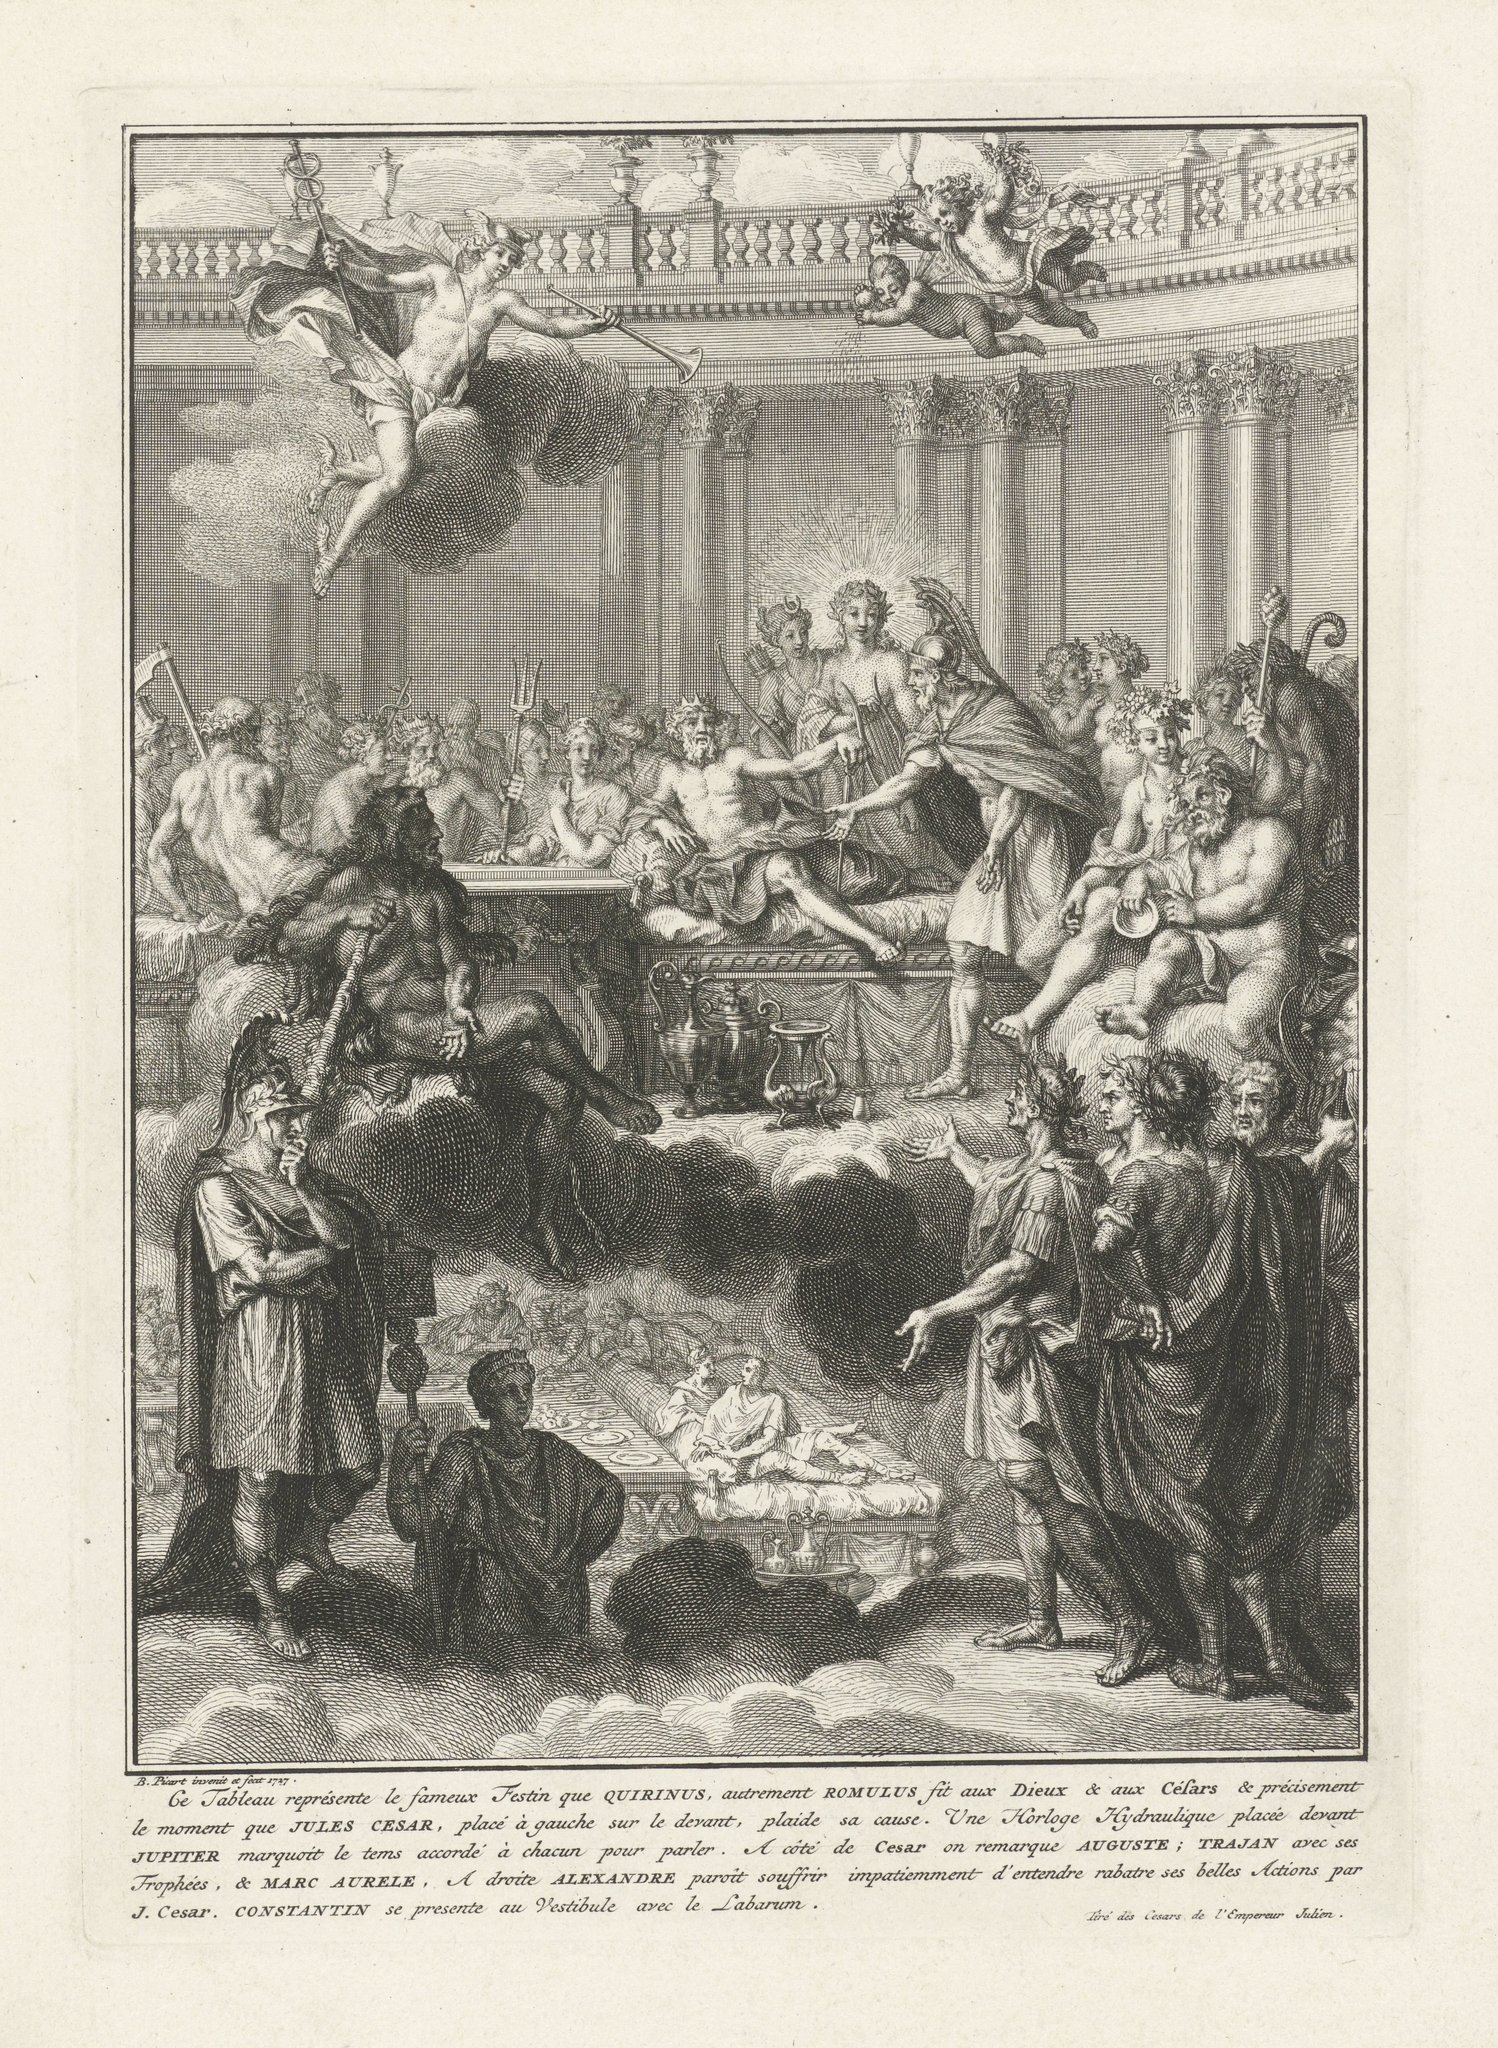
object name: print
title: Titelpagina voor: Flavius Claudius Julianus Apostata, Les cesars de l'empereur Julien, 1728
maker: bernard picart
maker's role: draughtsman, print maker, publisher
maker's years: 1673-1733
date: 1727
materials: paper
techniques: engraving, etching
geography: amsterdam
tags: romulus as king of rome, (instruments for) measurement of time, fluid mechanics, hydraulics, assemblies of the gods (in general), emperor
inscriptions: collector's mark: Lugt 240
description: In de hemel vindt een feest plaats dat Romulus organiseerde ter ere van de goden. Hij staat voor Jupiter die op een ligbed rust en bemiddelt met hem namens zijn opvolgers. Aan zijn voeten een instrument dat aanduidt hoe lang ze kunnen spreken. Rechts keizers Julius Caesar, Augustus, Trajanus en Marcus Aurelius. Links Hercules die wijst op Alexander de Grote die weer bedenkelijk kijkt naar de anderen. In de marge een vijfregelig onderschrift in het Frans.